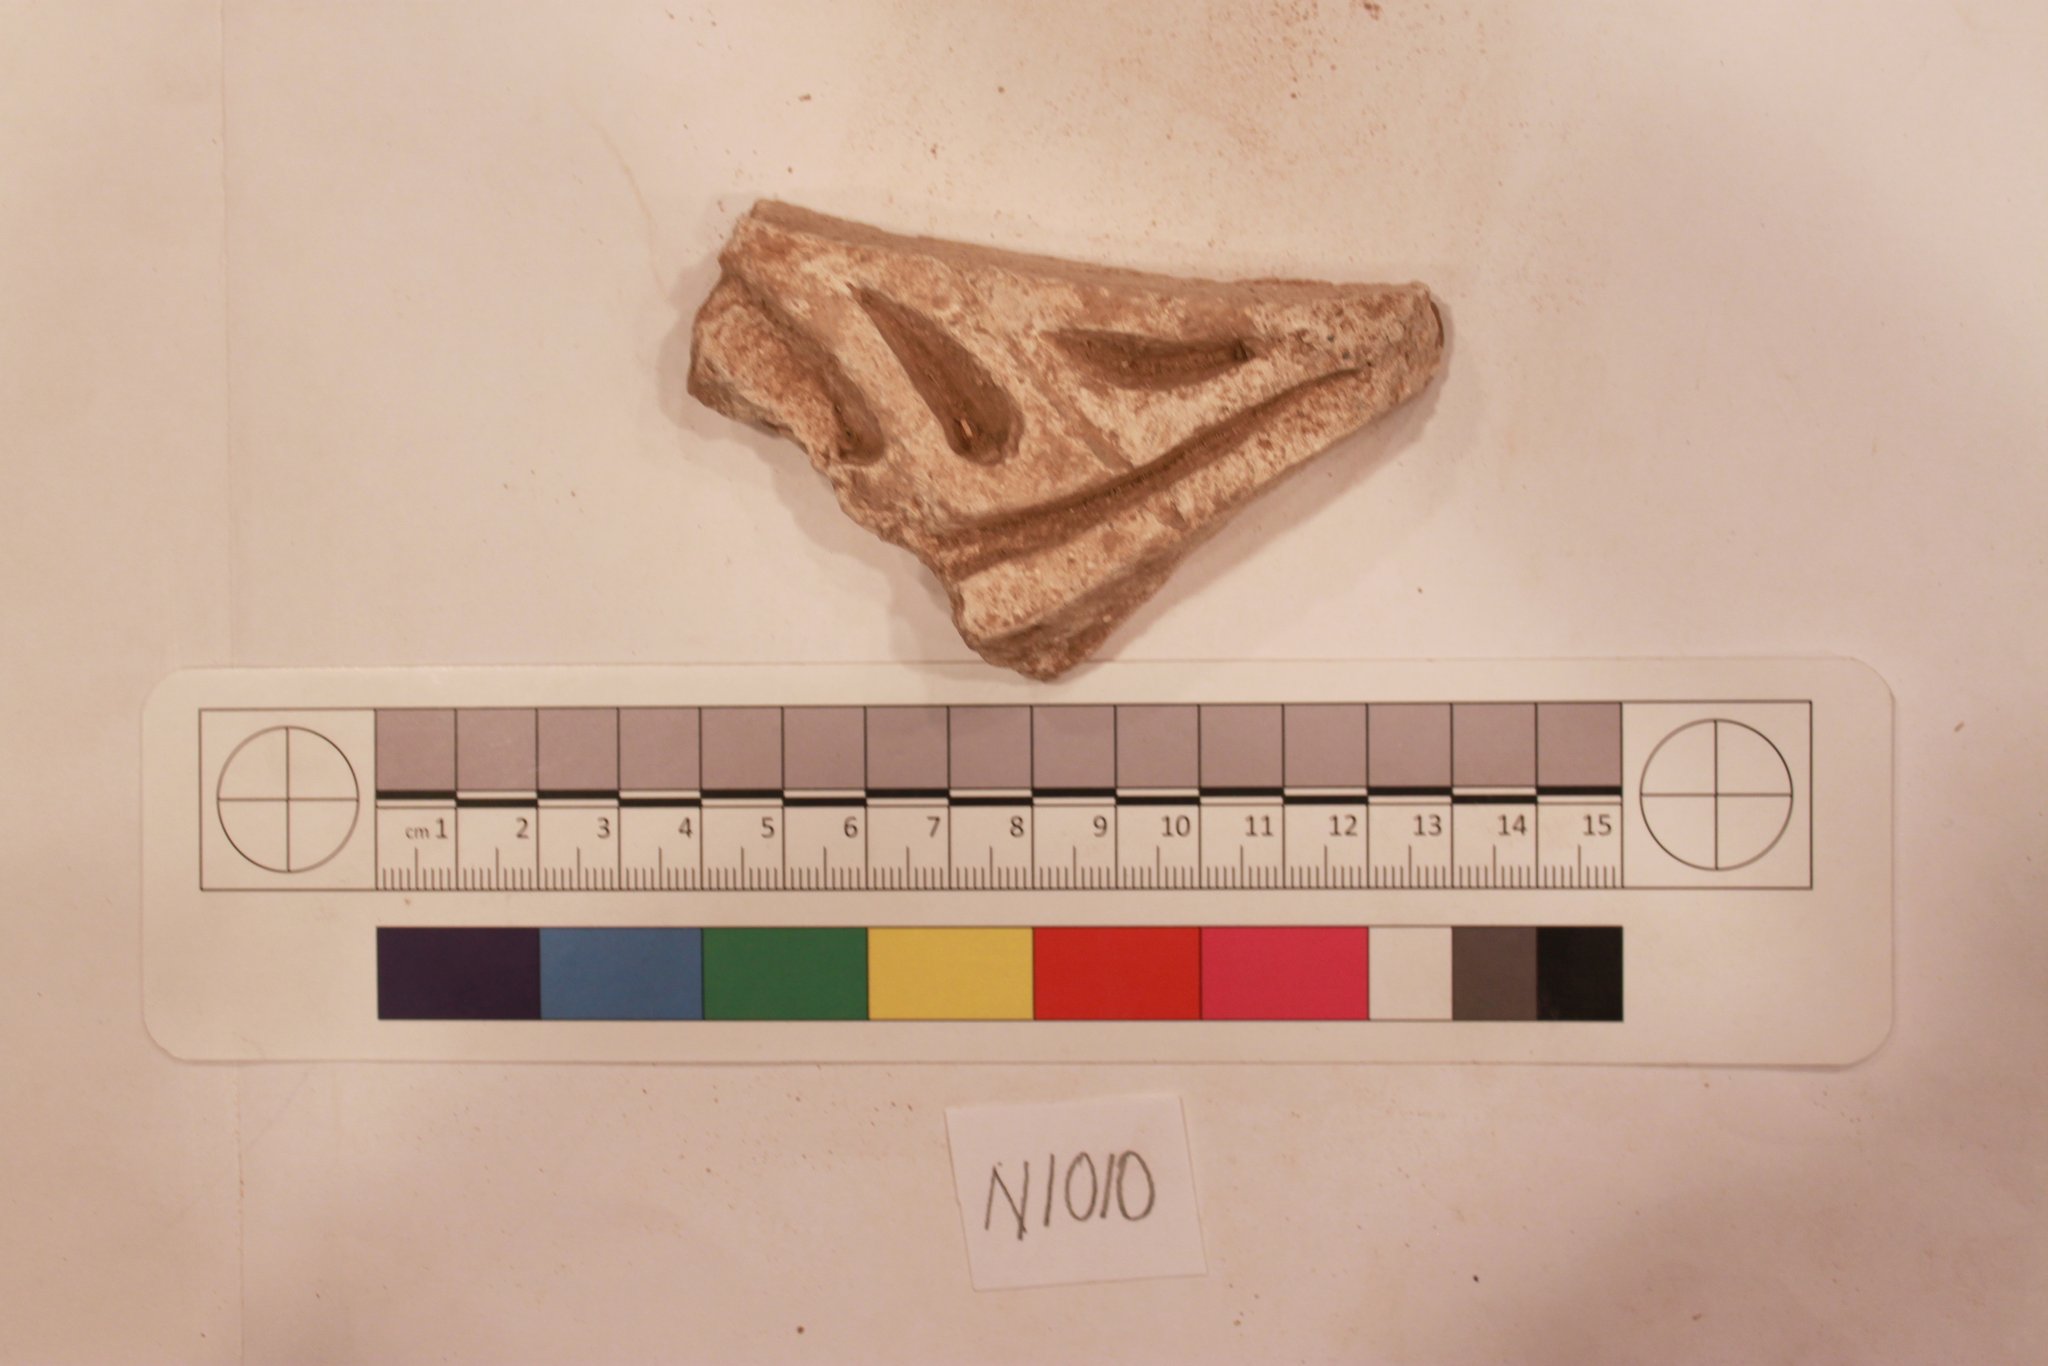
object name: fragment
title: Stucco Fragment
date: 701-1200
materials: plaster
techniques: carving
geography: iran